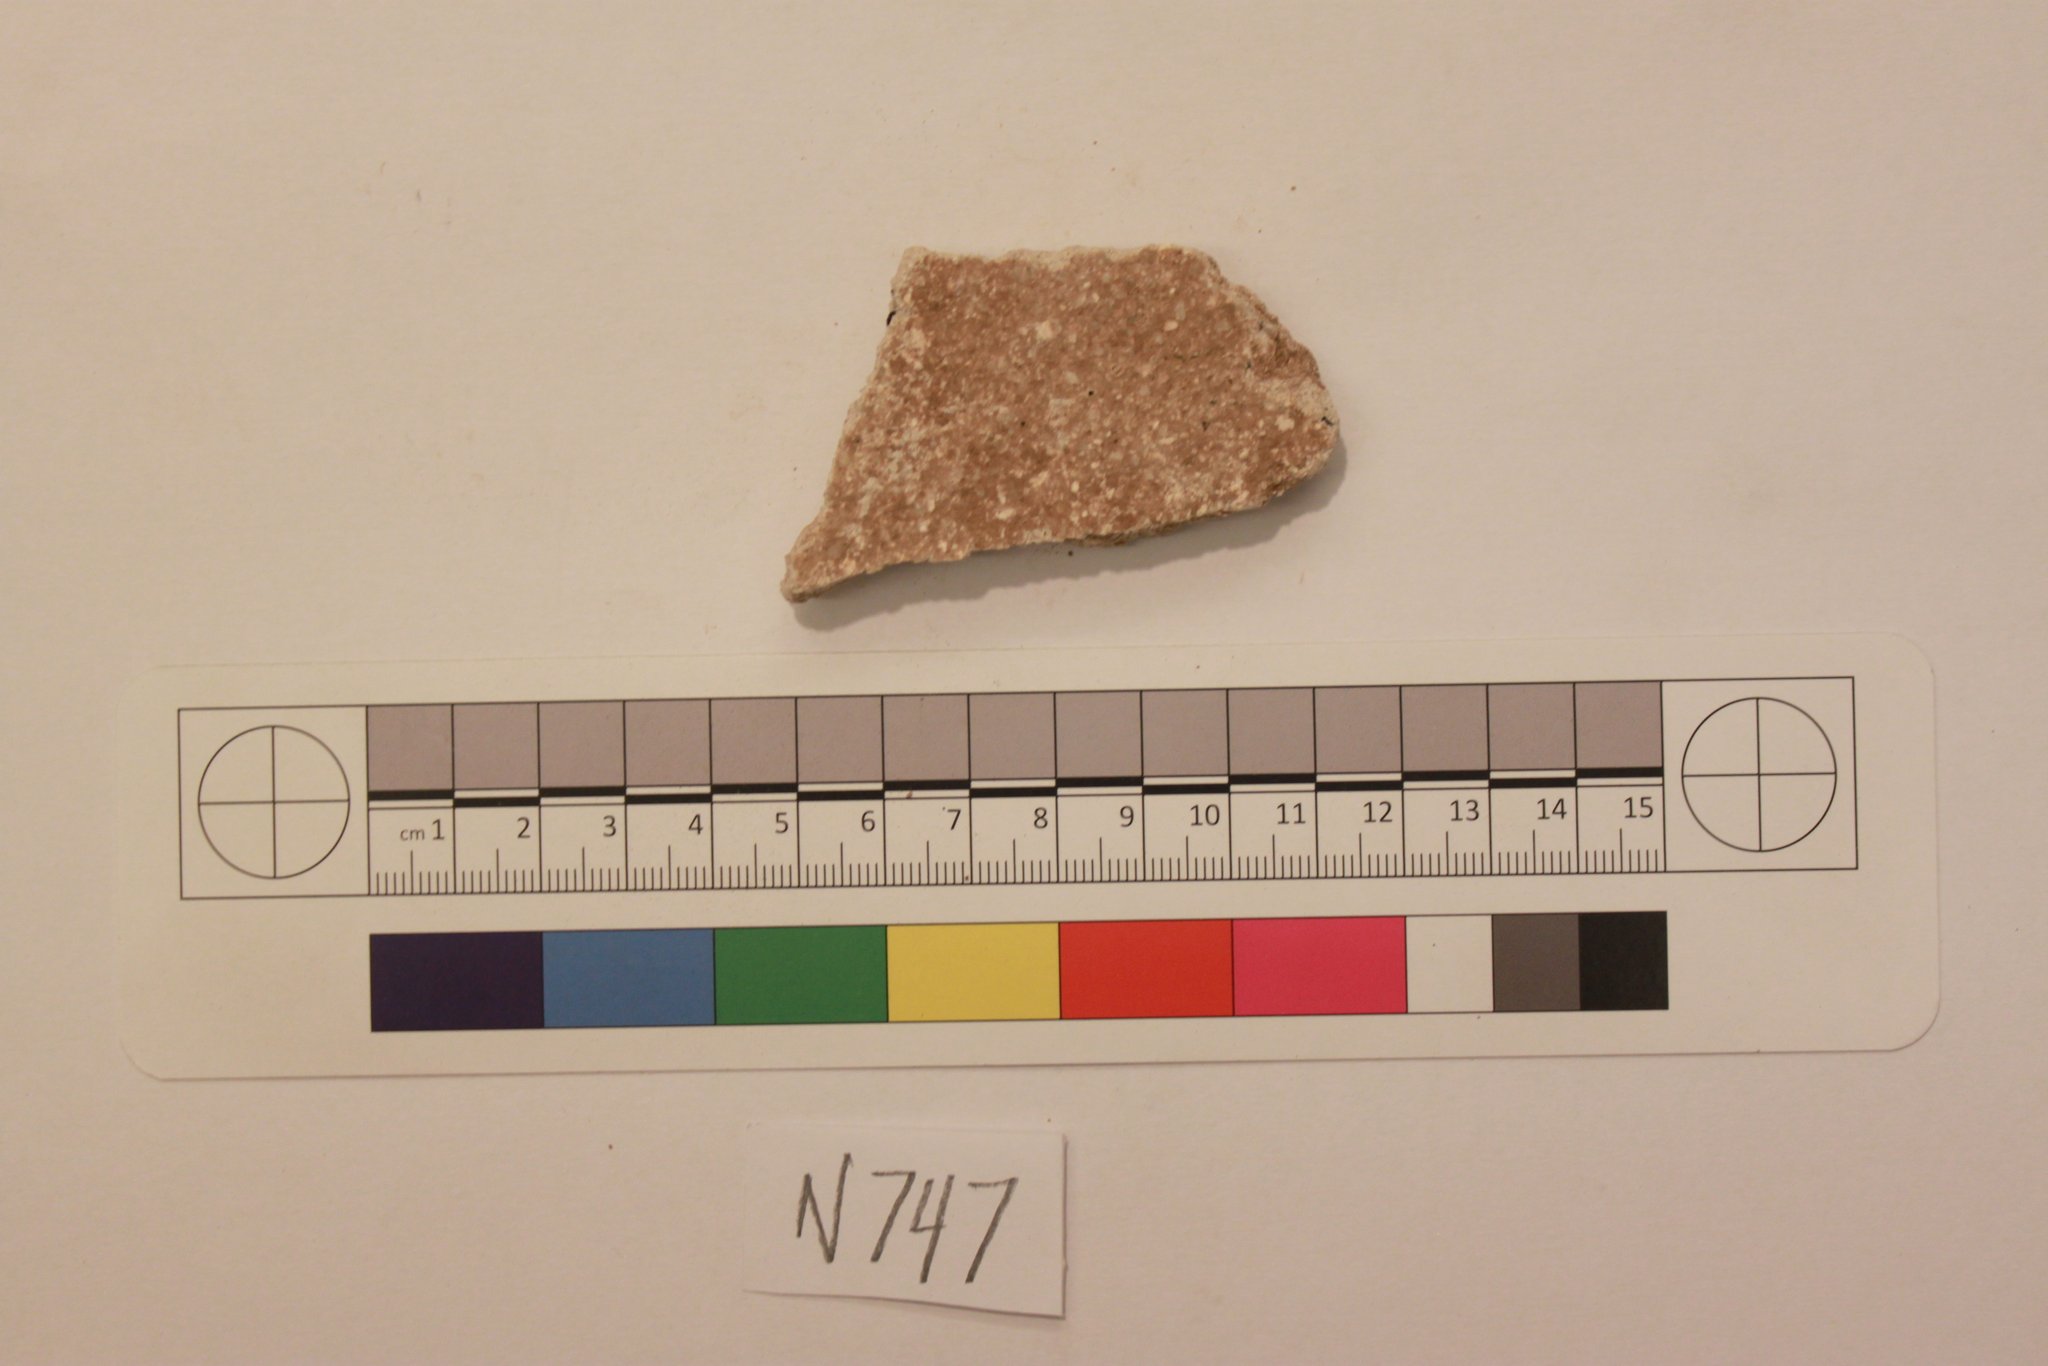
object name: fragment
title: Stucco Fragment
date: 701-1200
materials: plaster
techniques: carving, painting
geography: iran